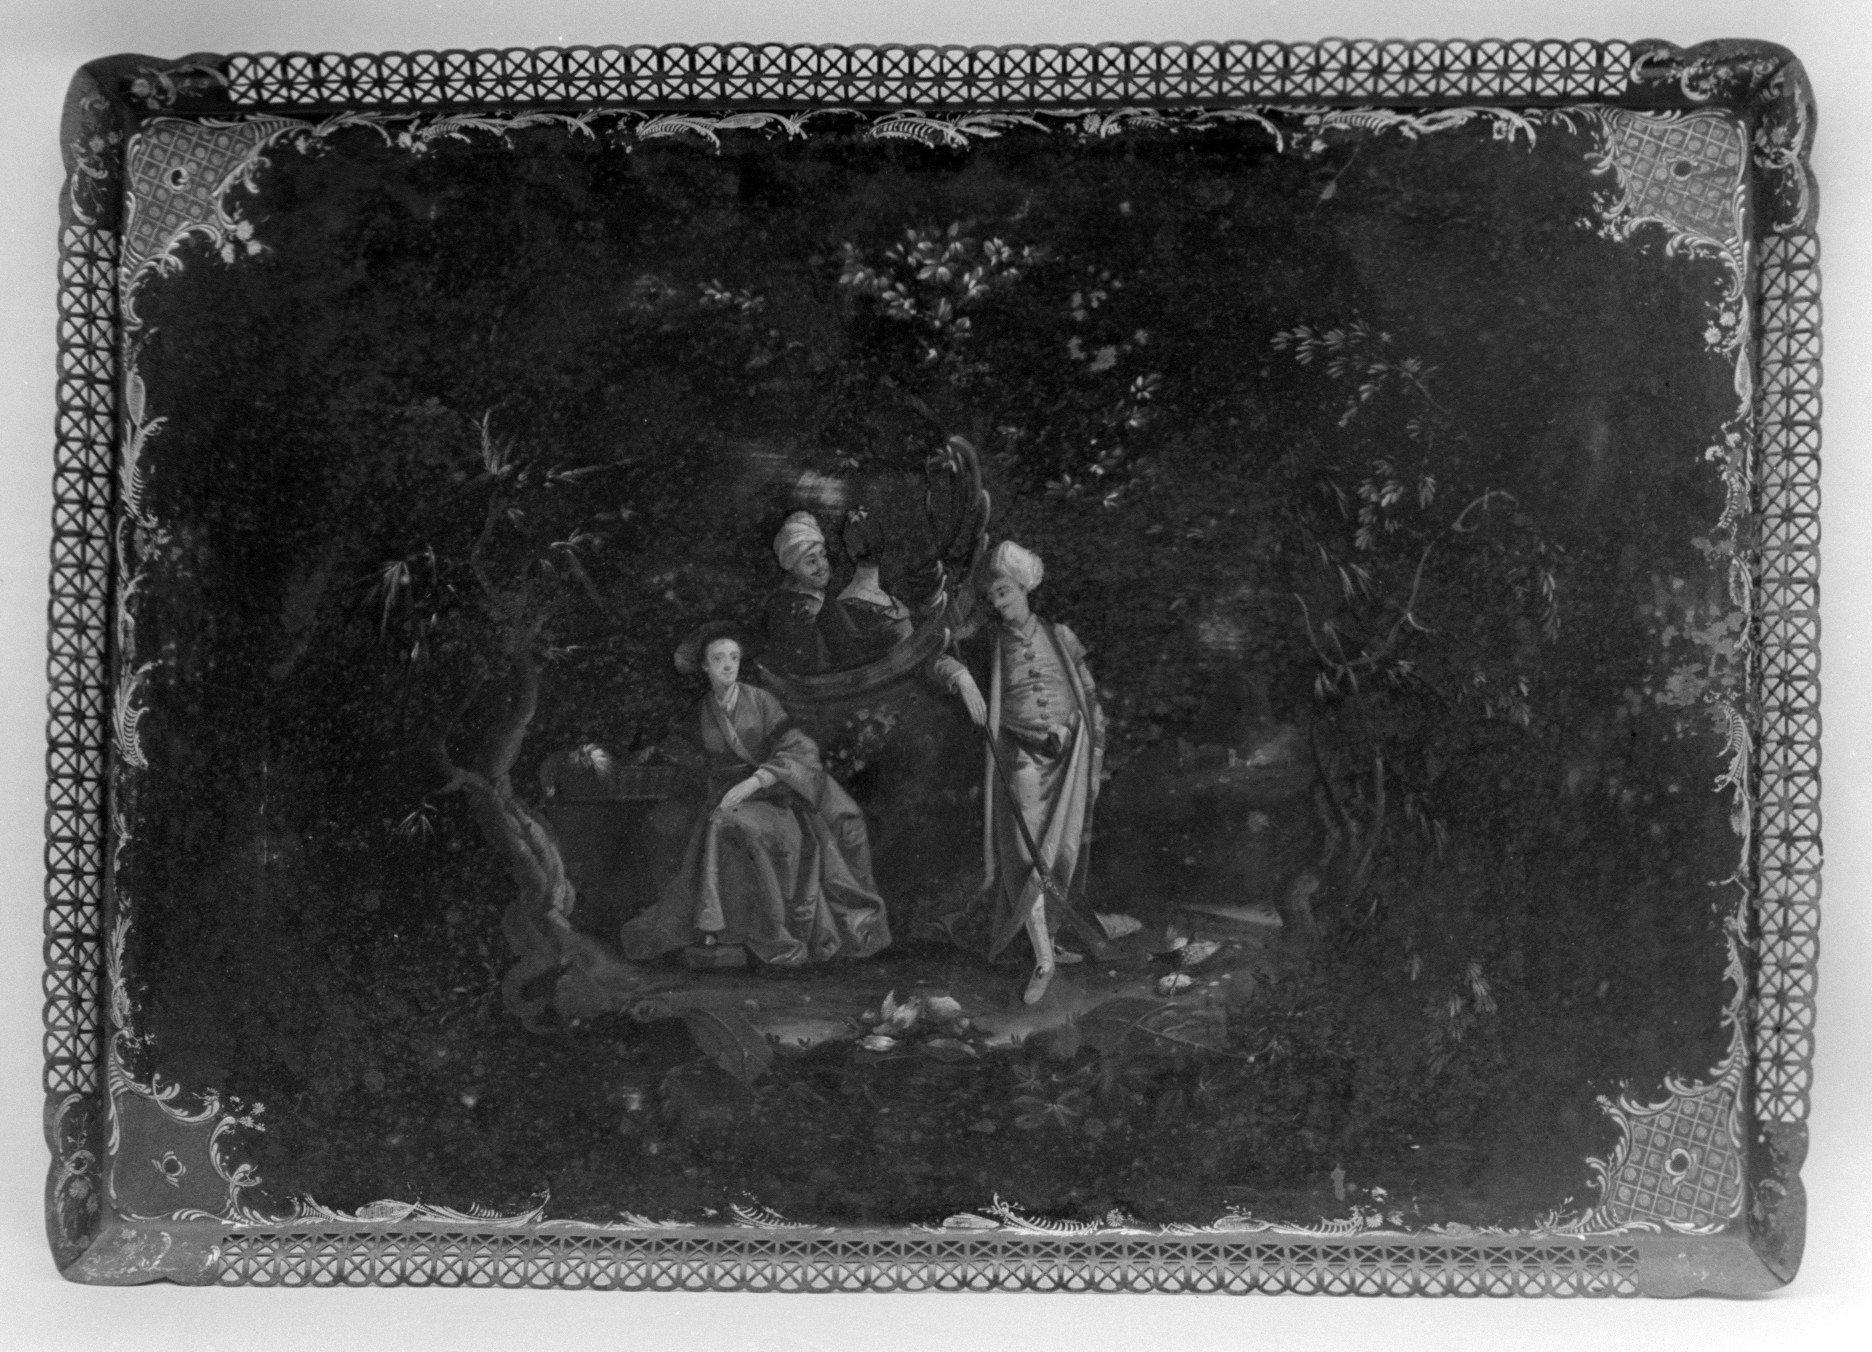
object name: tray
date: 1701-1800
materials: iron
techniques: painting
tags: men,women